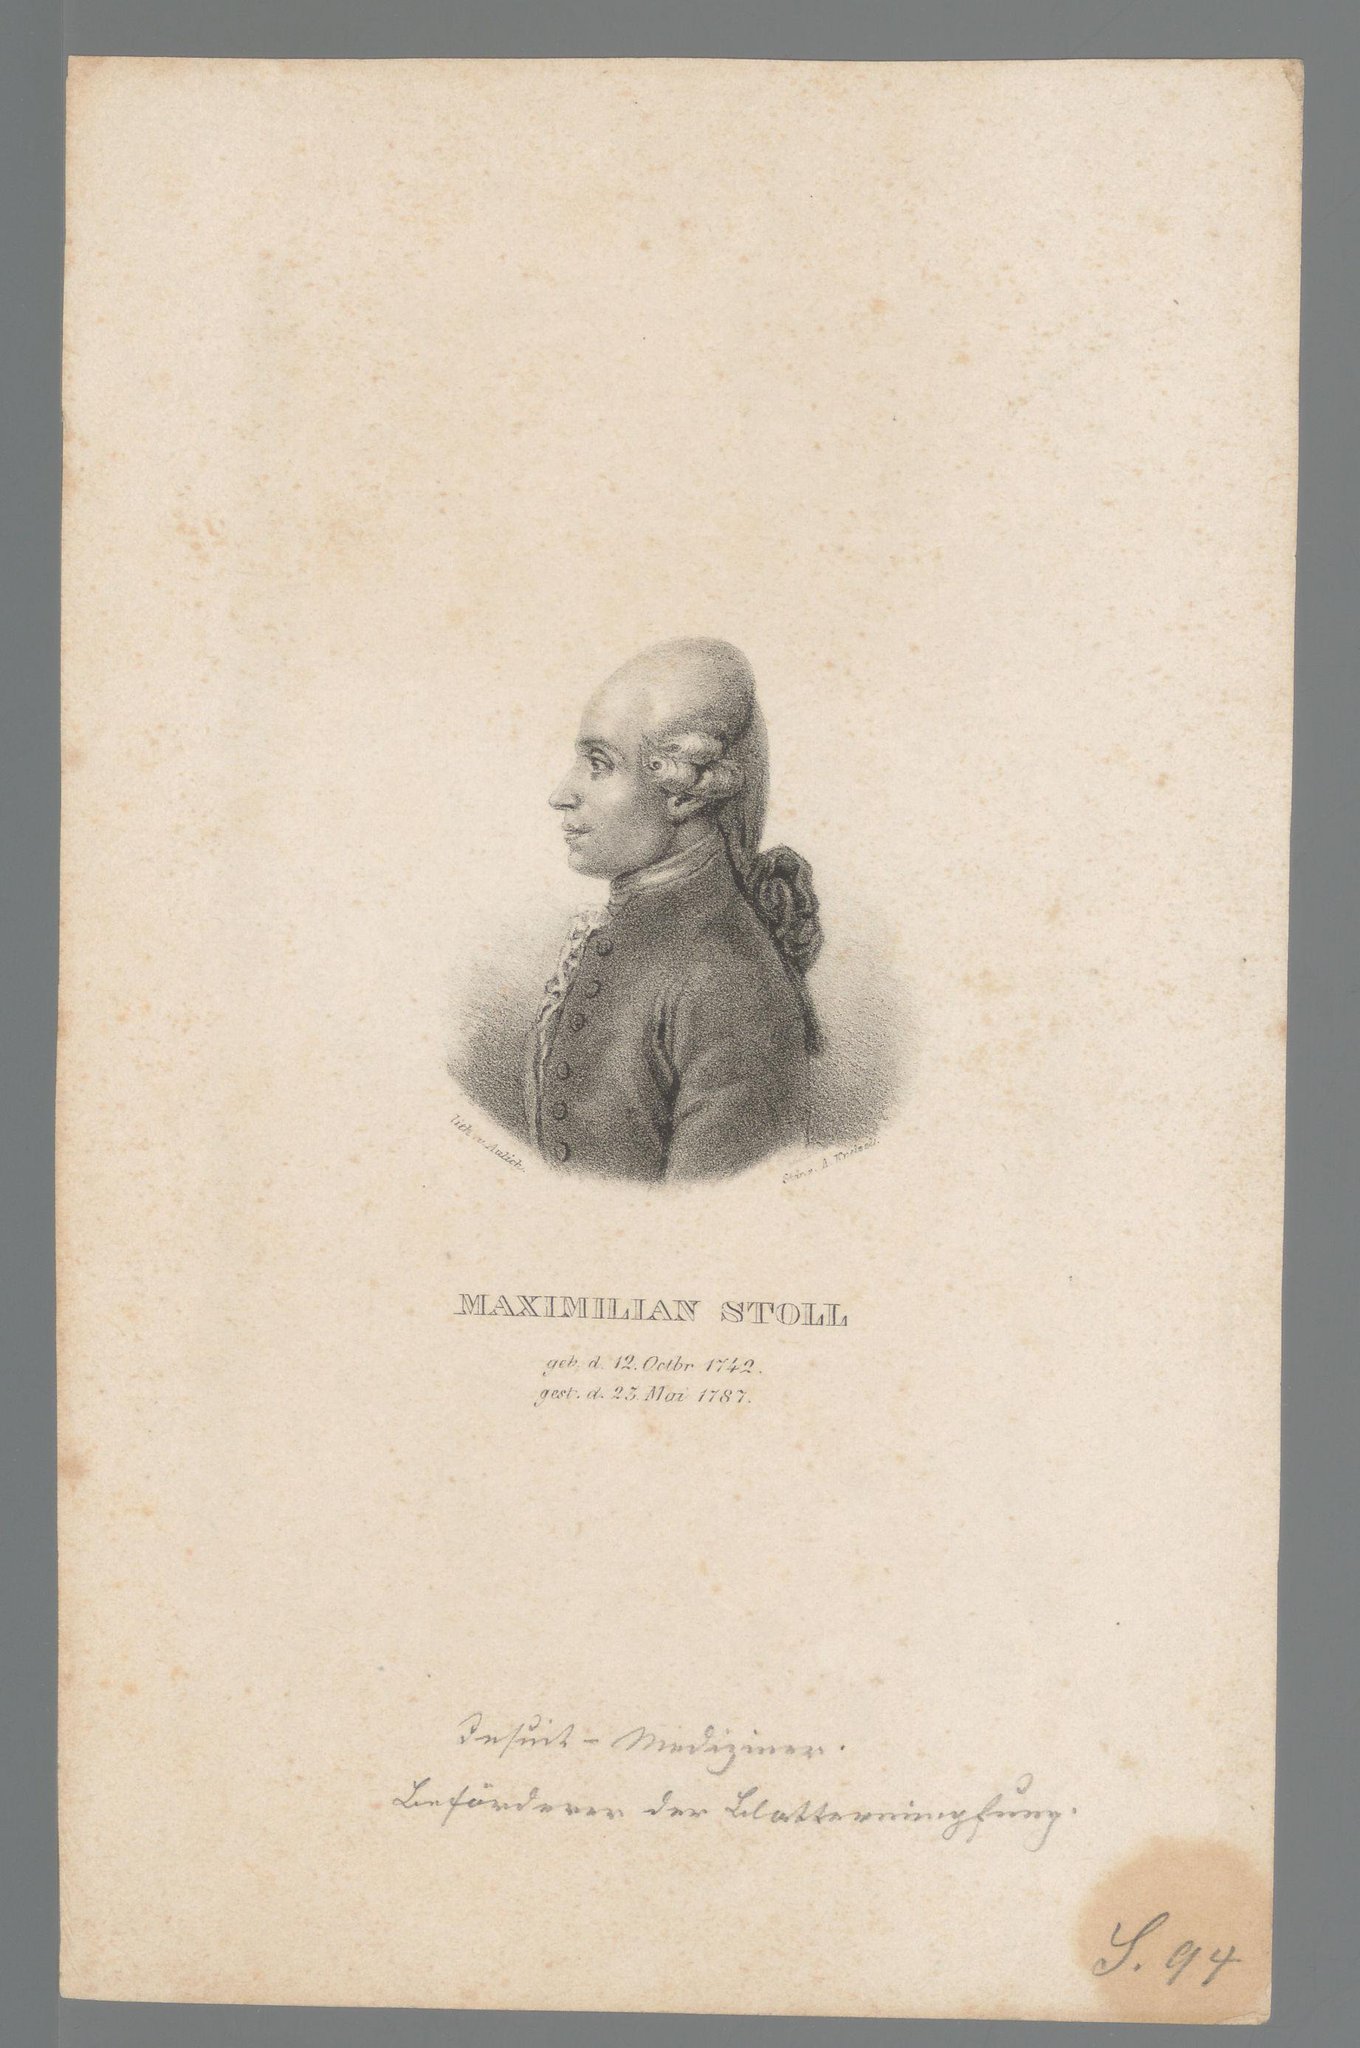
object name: print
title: Portret van Maximilian Stoll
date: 1792-1855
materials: paper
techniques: lithograph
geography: leipzig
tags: vienna, adult man, historical persons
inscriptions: collector's mark: Lugt 2228